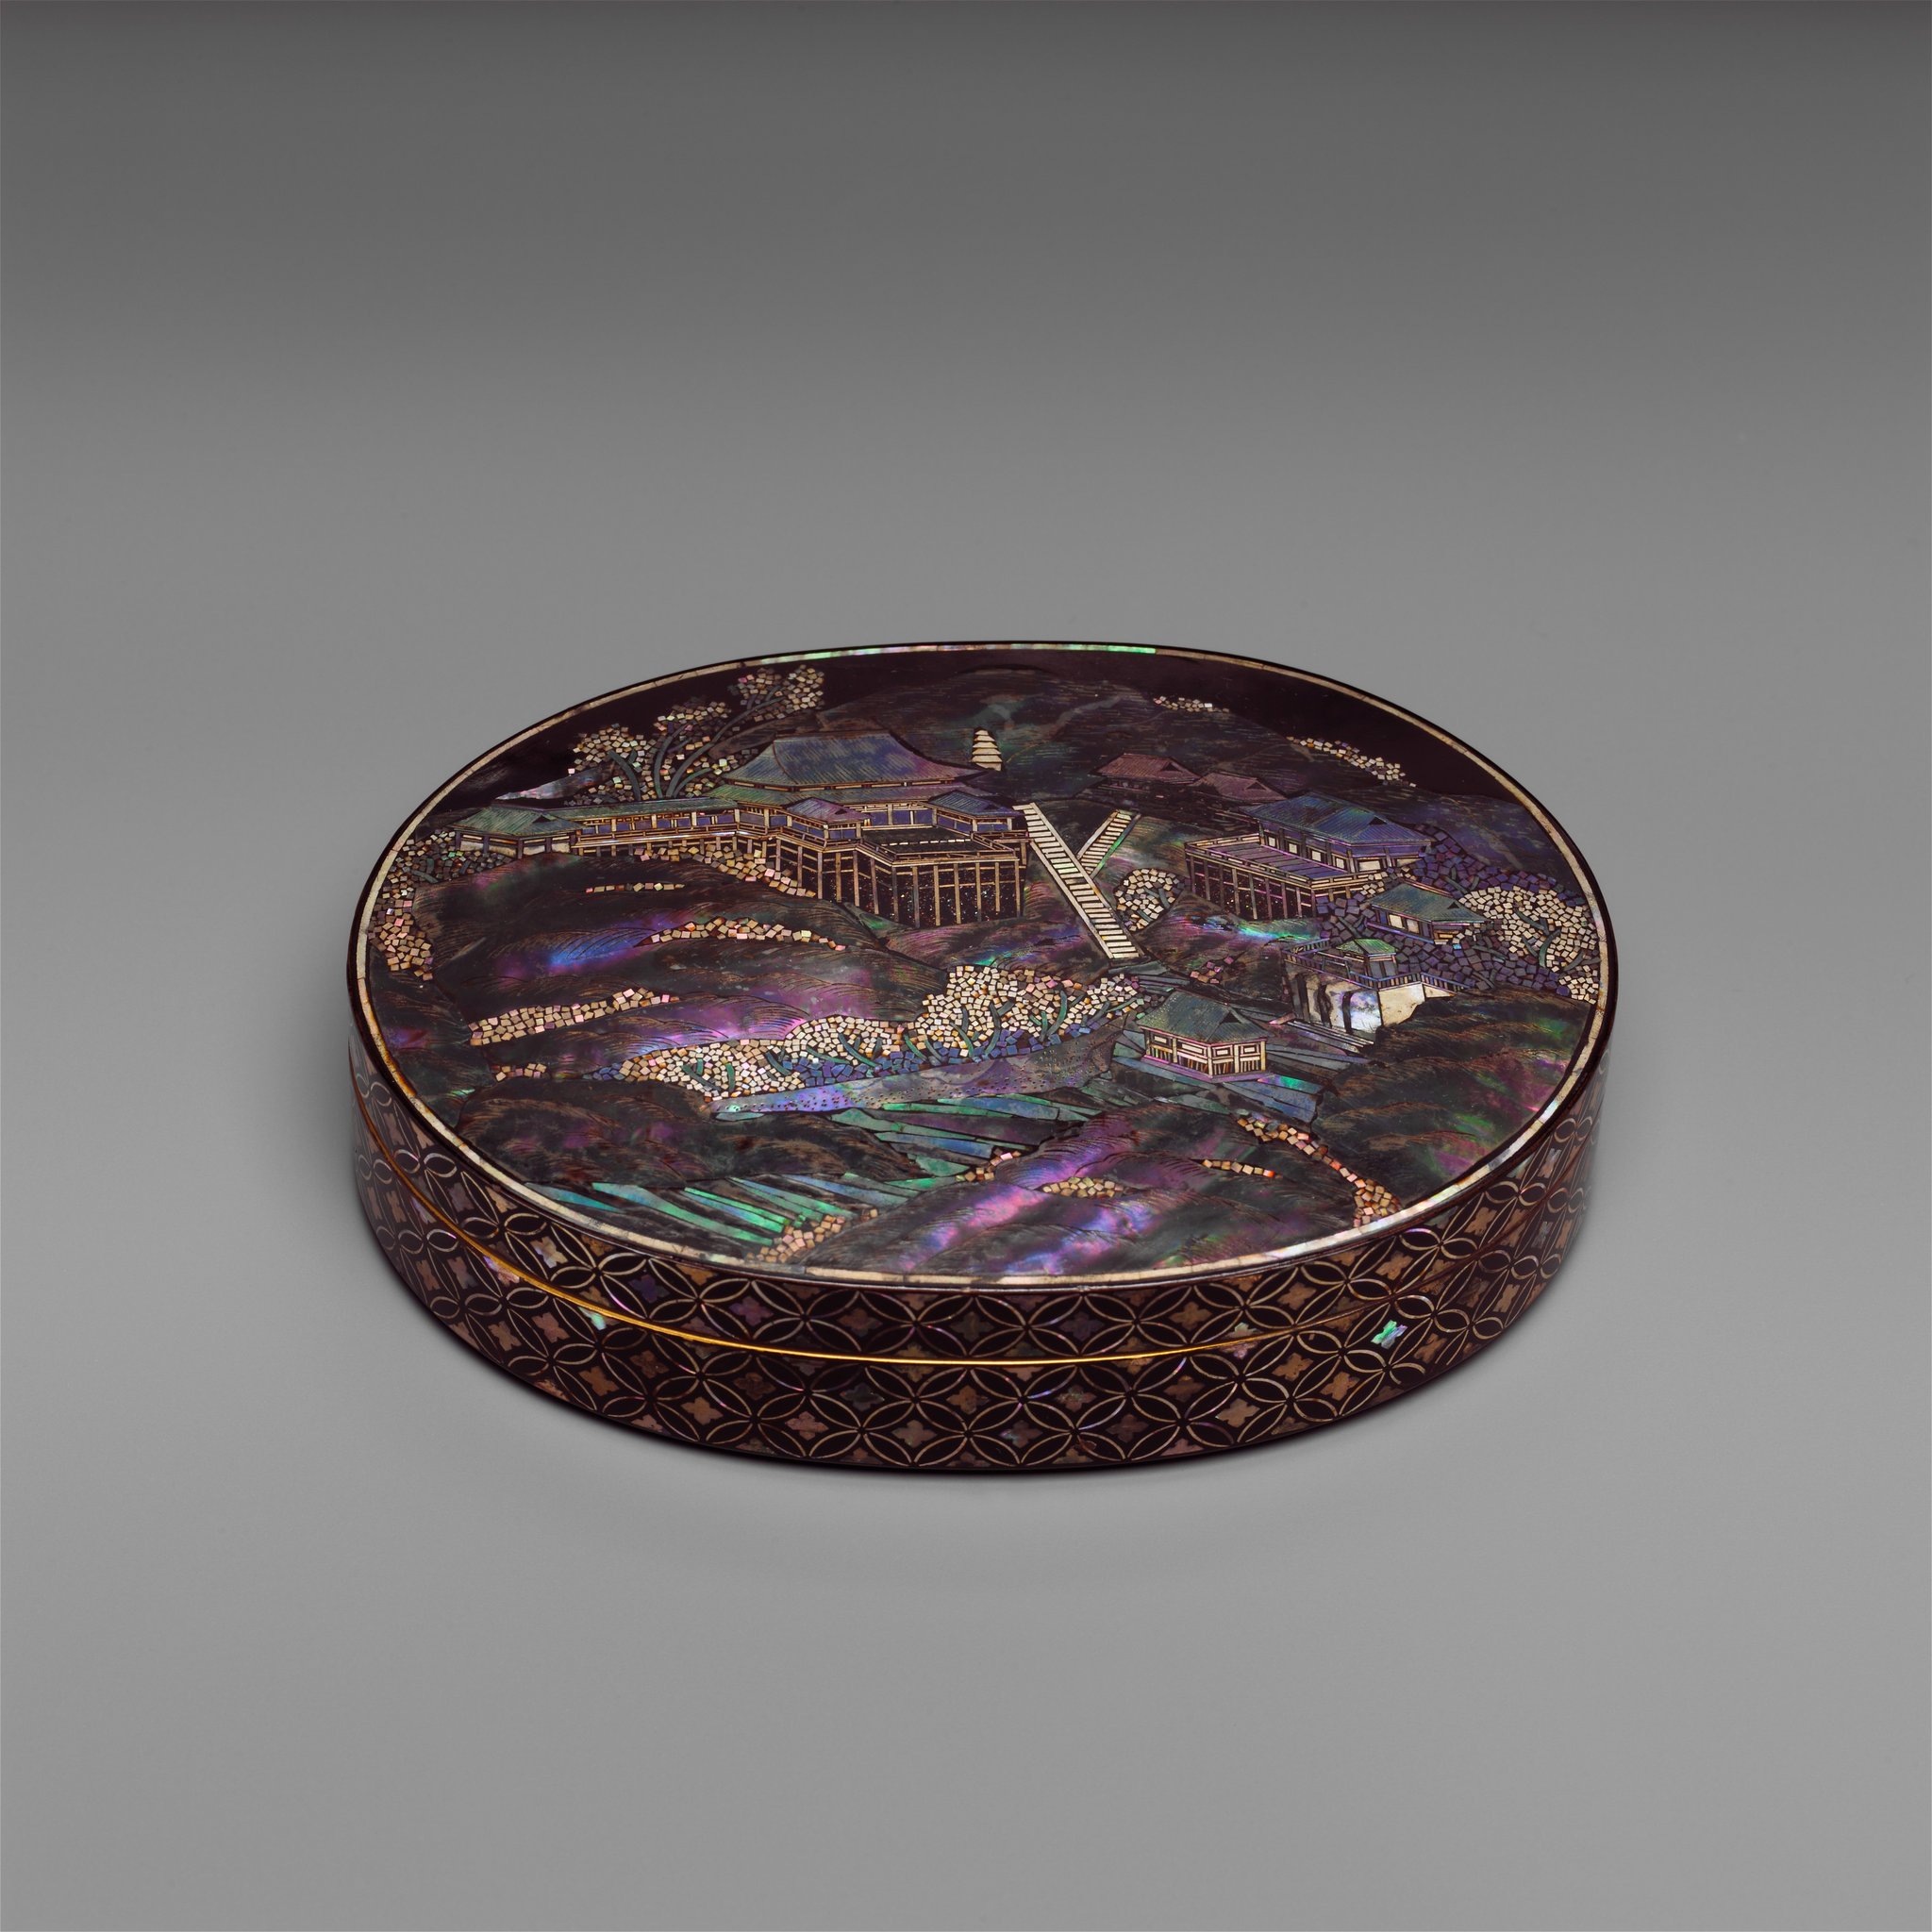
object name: box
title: Small Box with Scene of Kiyomizudera Temple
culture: japanese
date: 1801-1833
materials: copper, lacquer, pearl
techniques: inlay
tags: temples